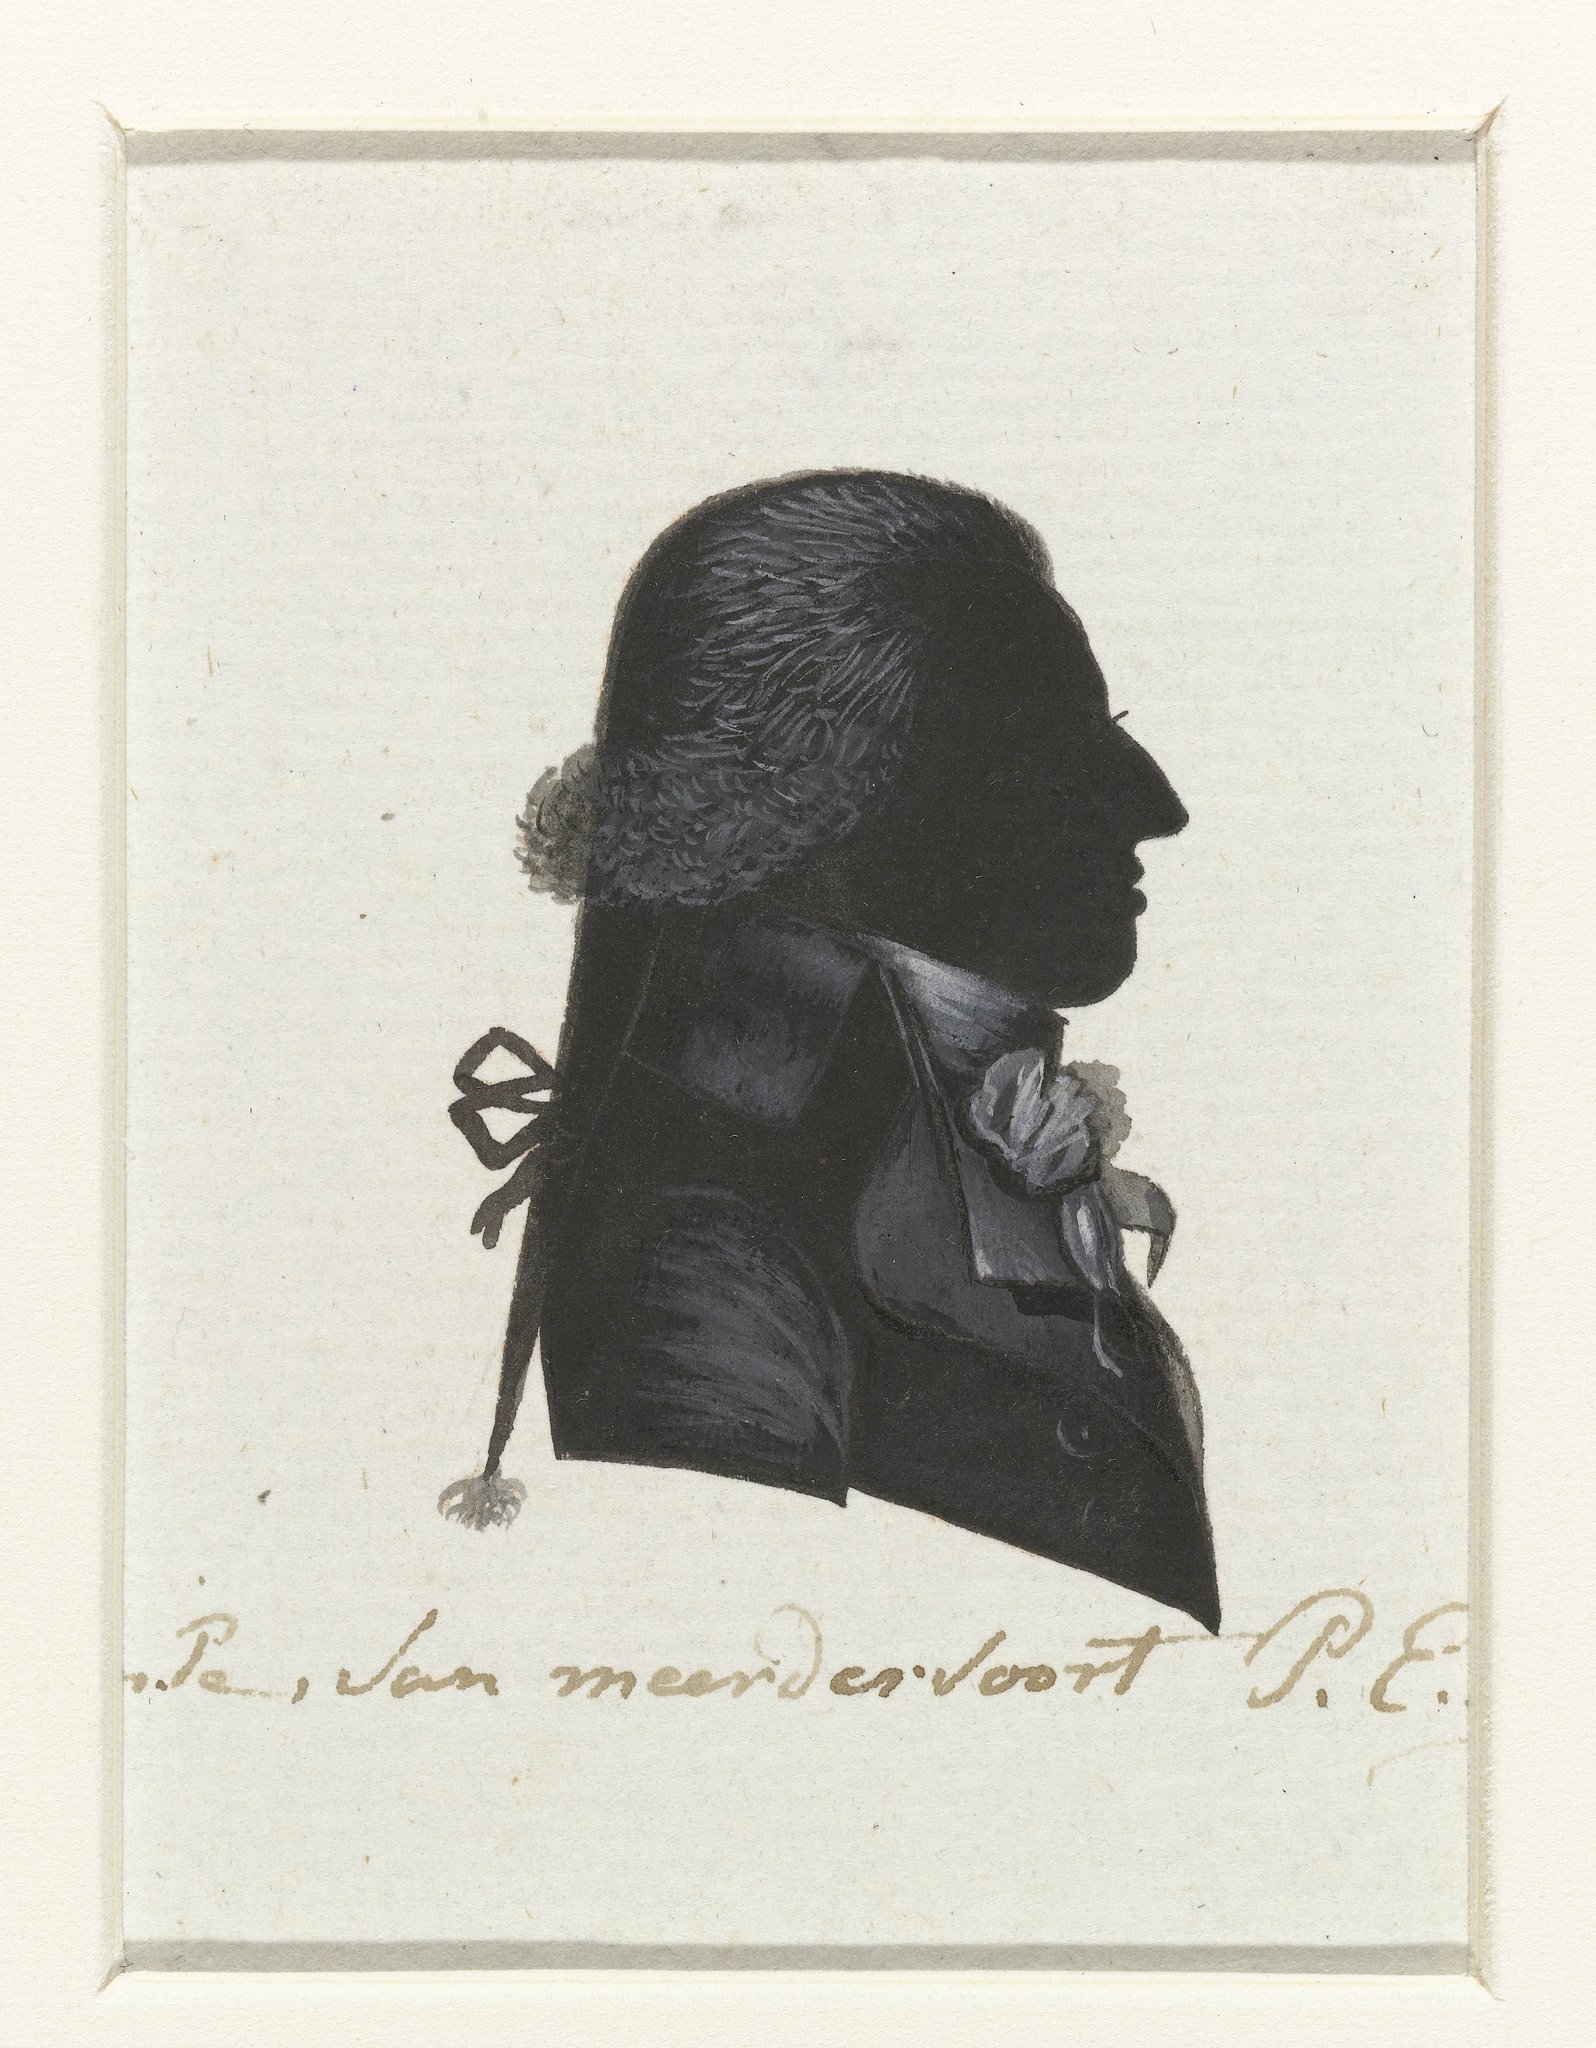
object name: silhouette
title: P.E. Pompe van Meerdervoort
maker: hausdorff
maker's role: draughtsman, print maker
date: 1796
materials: ink, paper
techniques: drawing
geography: netherlands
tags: historical persons (+ profile portrait), the hague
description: Silhouettes of members of the National Assembly. India ink on paper, 1796. Early in 1795 Stadholder William V fled to England. In the Republic a new regime was installed. A year later, the country held its first general election. Every Dutch man over the age of twenty and not on poor relief was entitled to vote for a candidate to the National Assembly, the parliament of the Batavian Republic, as the country was known between 1795 and 1806. The 126 representatives who sat in the assembly were drawn from the educated, progressive elite of Dutch society.